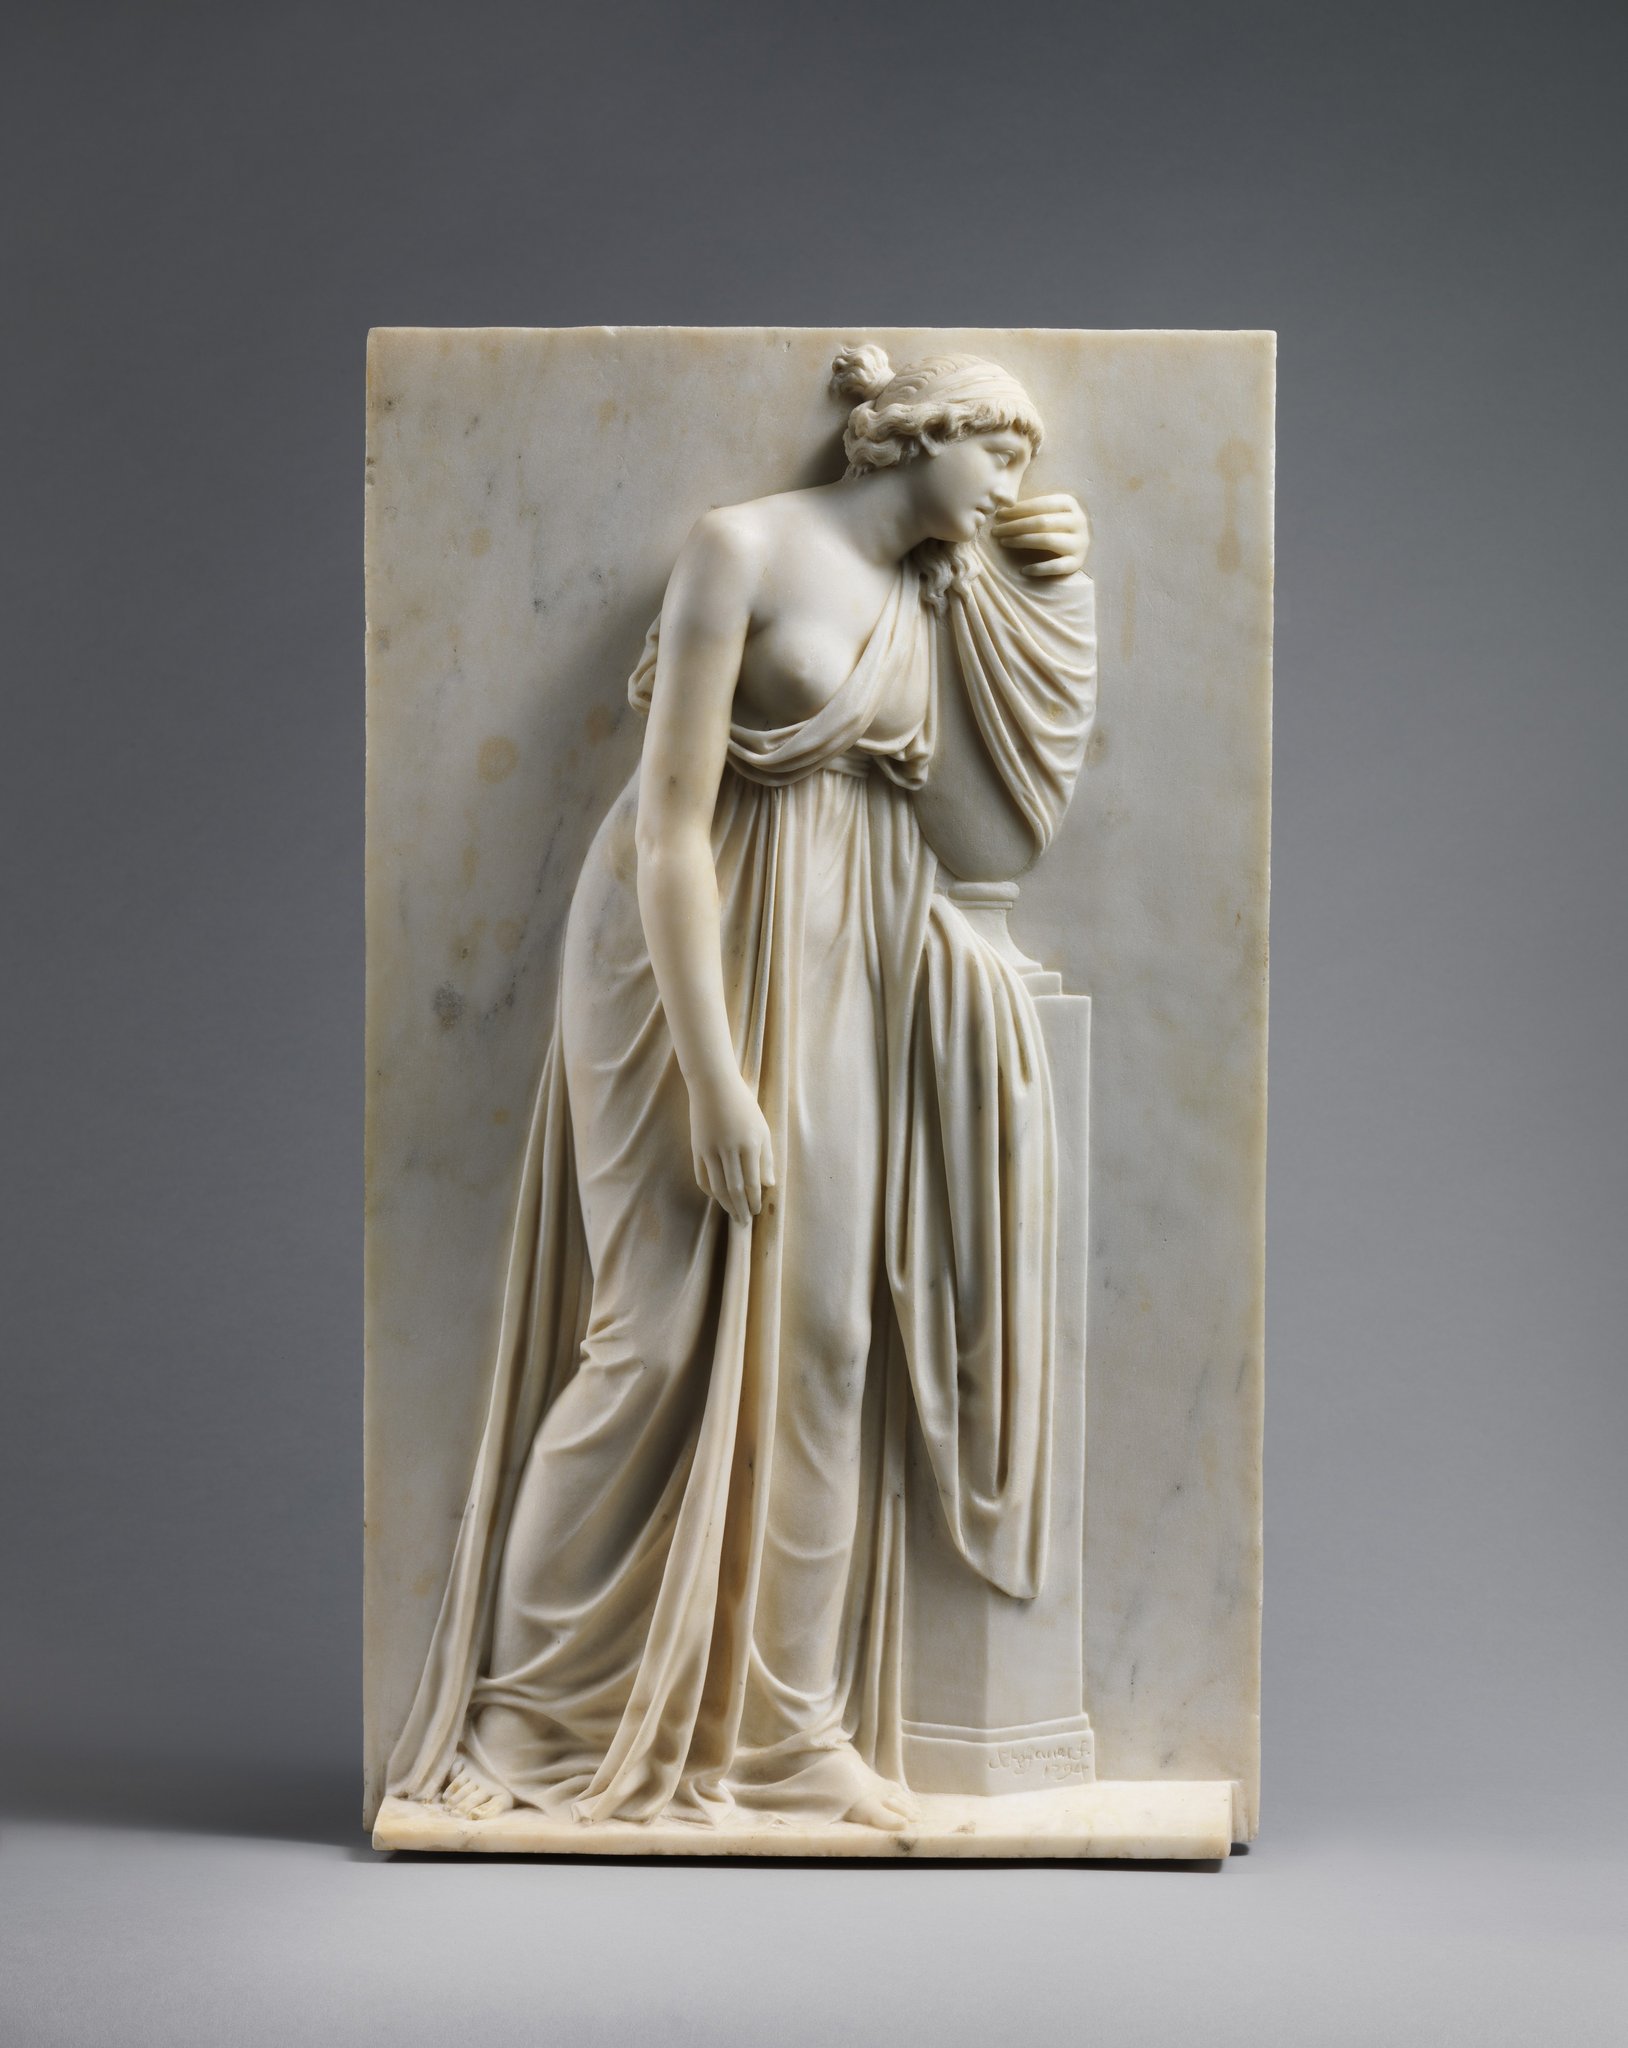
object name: relief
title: Artemisia in Mourning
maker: philipp jakob scheffauer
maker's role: artist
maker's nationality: german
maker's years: 1756-1808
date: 1794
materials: marble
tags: sadness,women